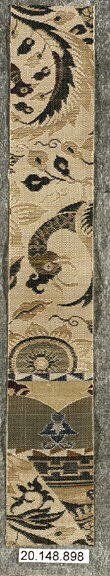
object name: textile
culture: china or japan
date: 1701-1800